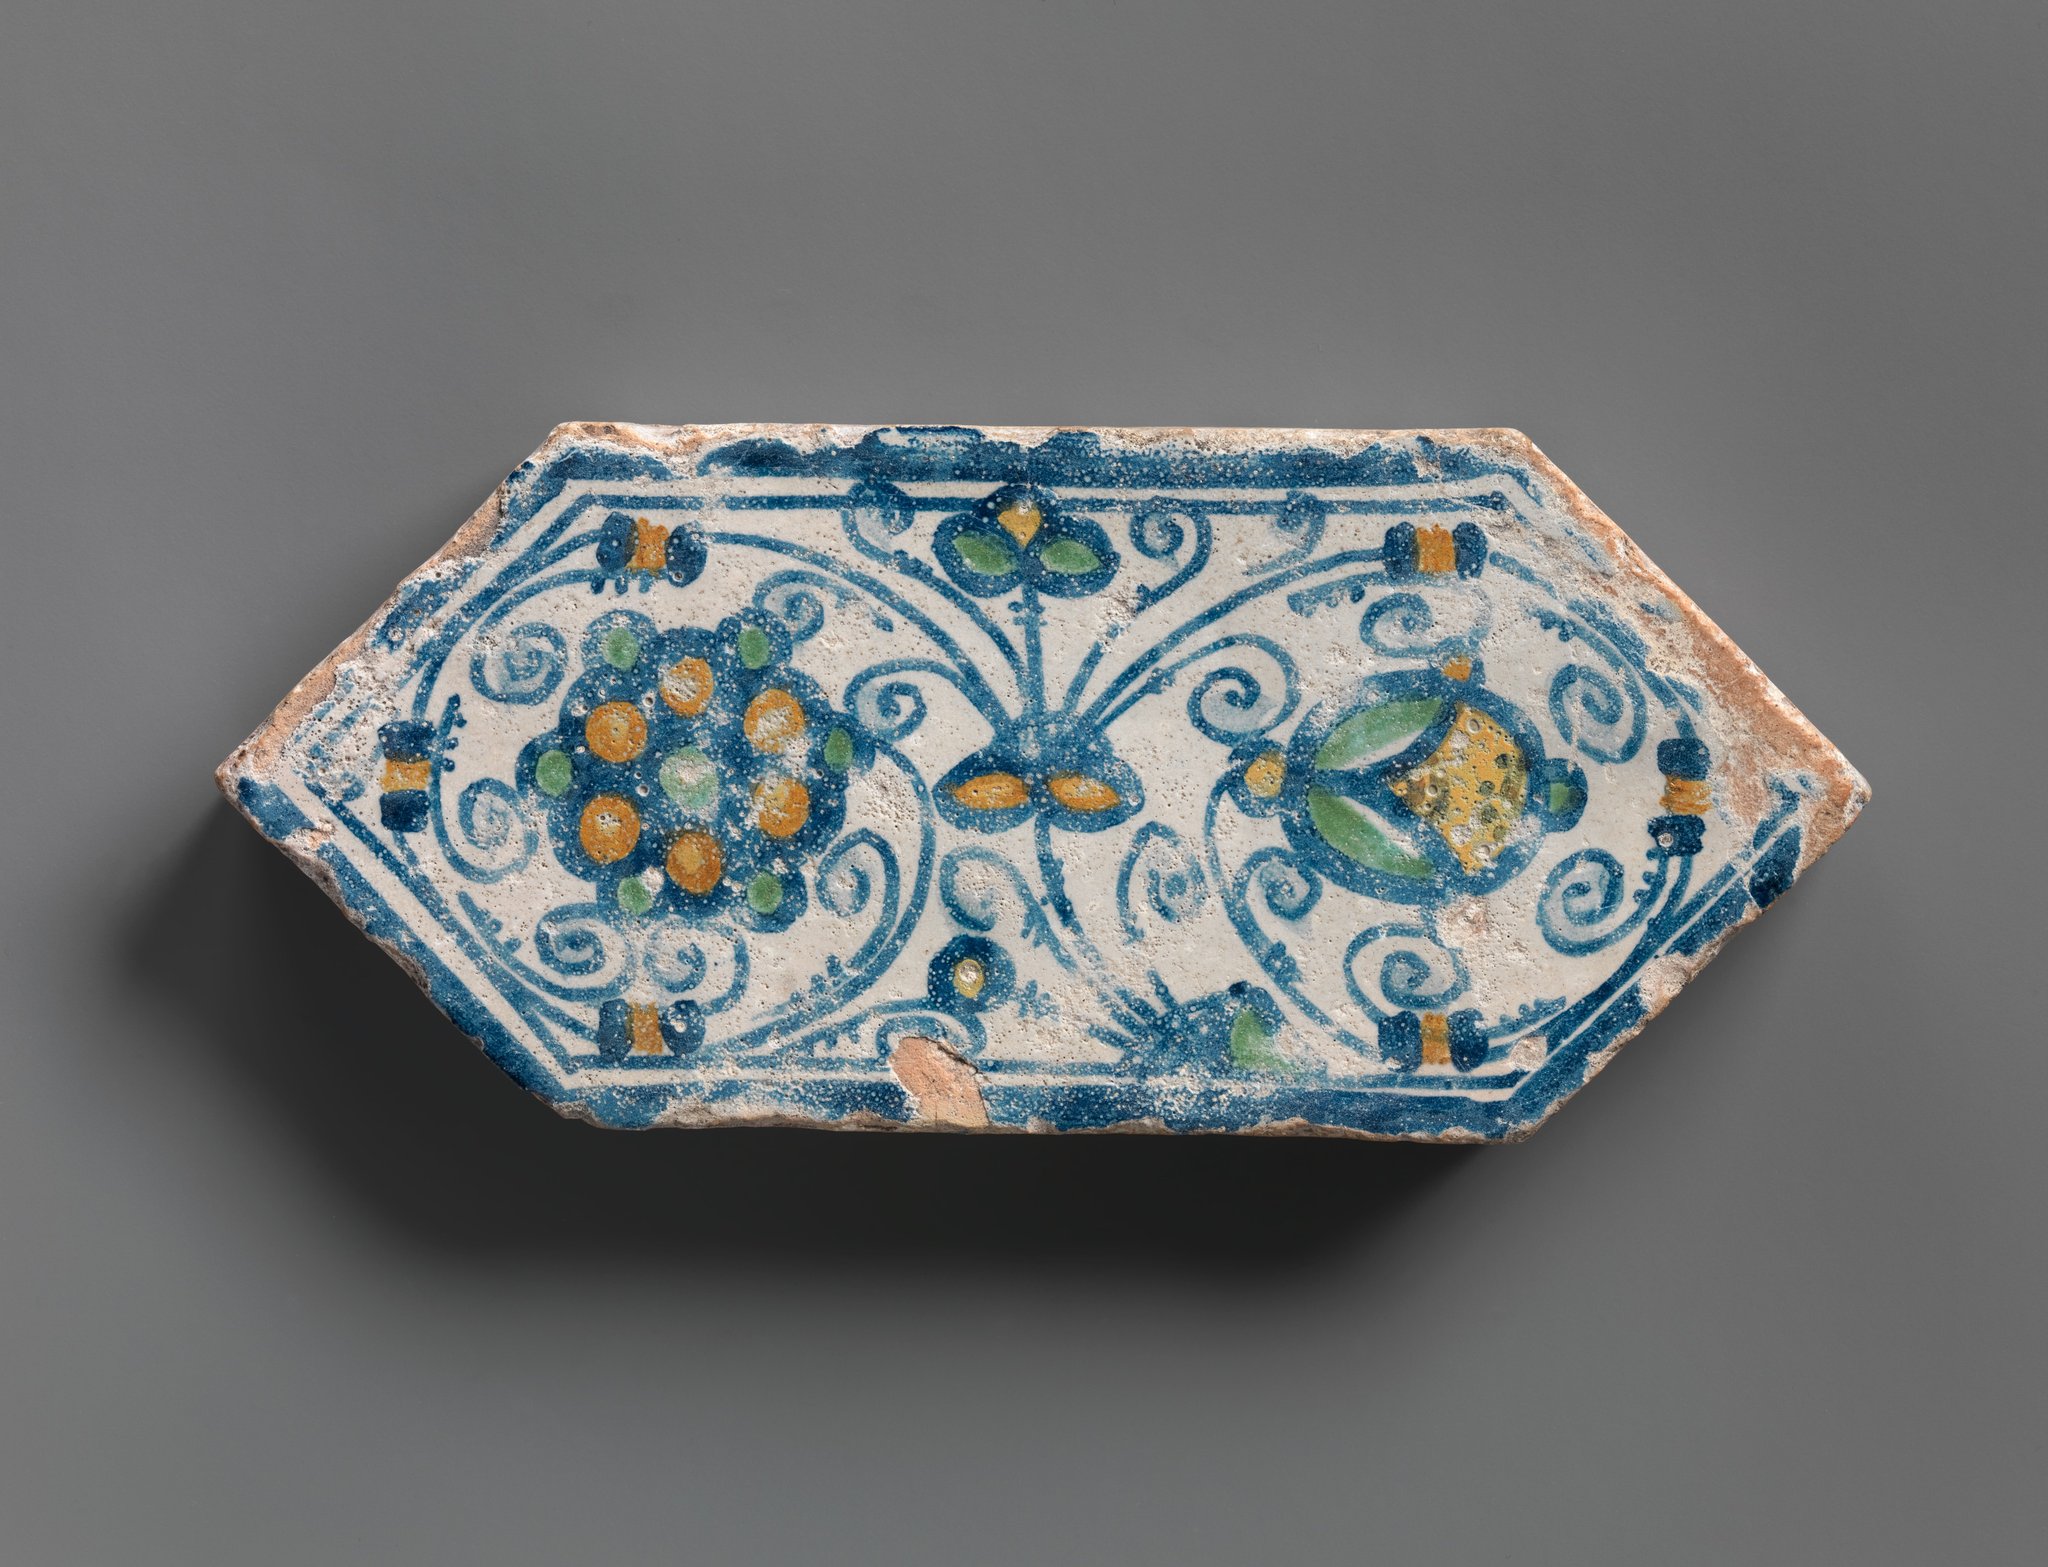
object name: tile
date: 1530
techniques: maiolica, glazing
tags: flowers